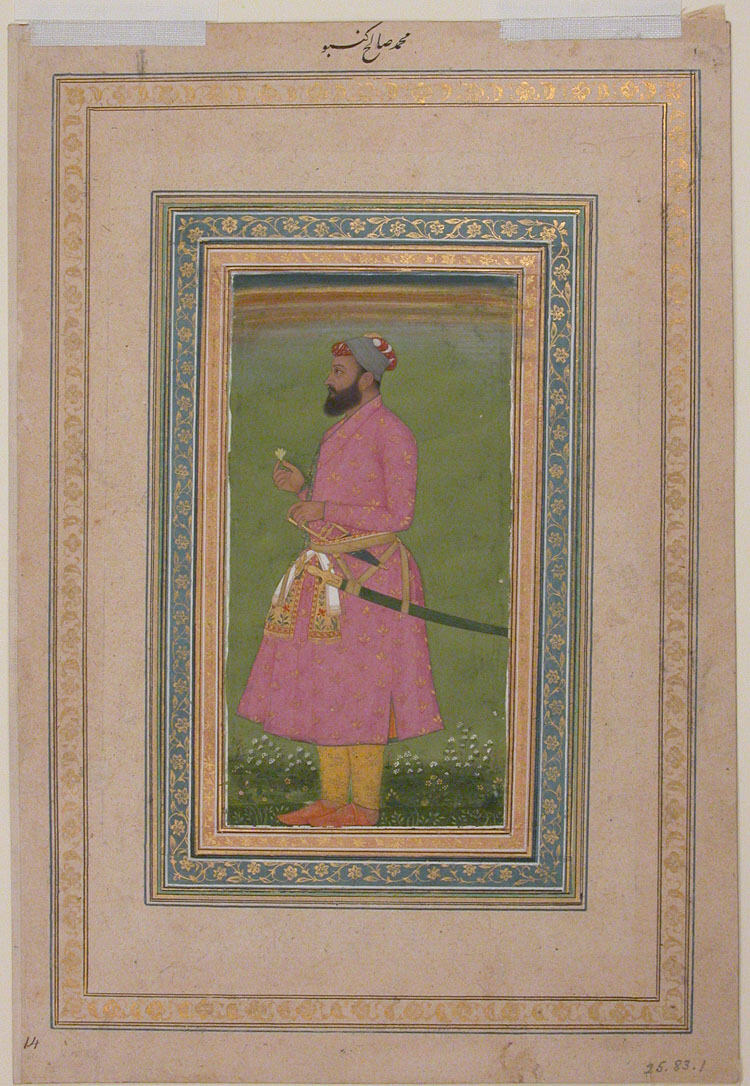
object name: album leaf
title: Portrait of Muhammad Salih Kambu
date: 1601-1700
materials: paper, watercolor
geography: india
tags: men,profiles